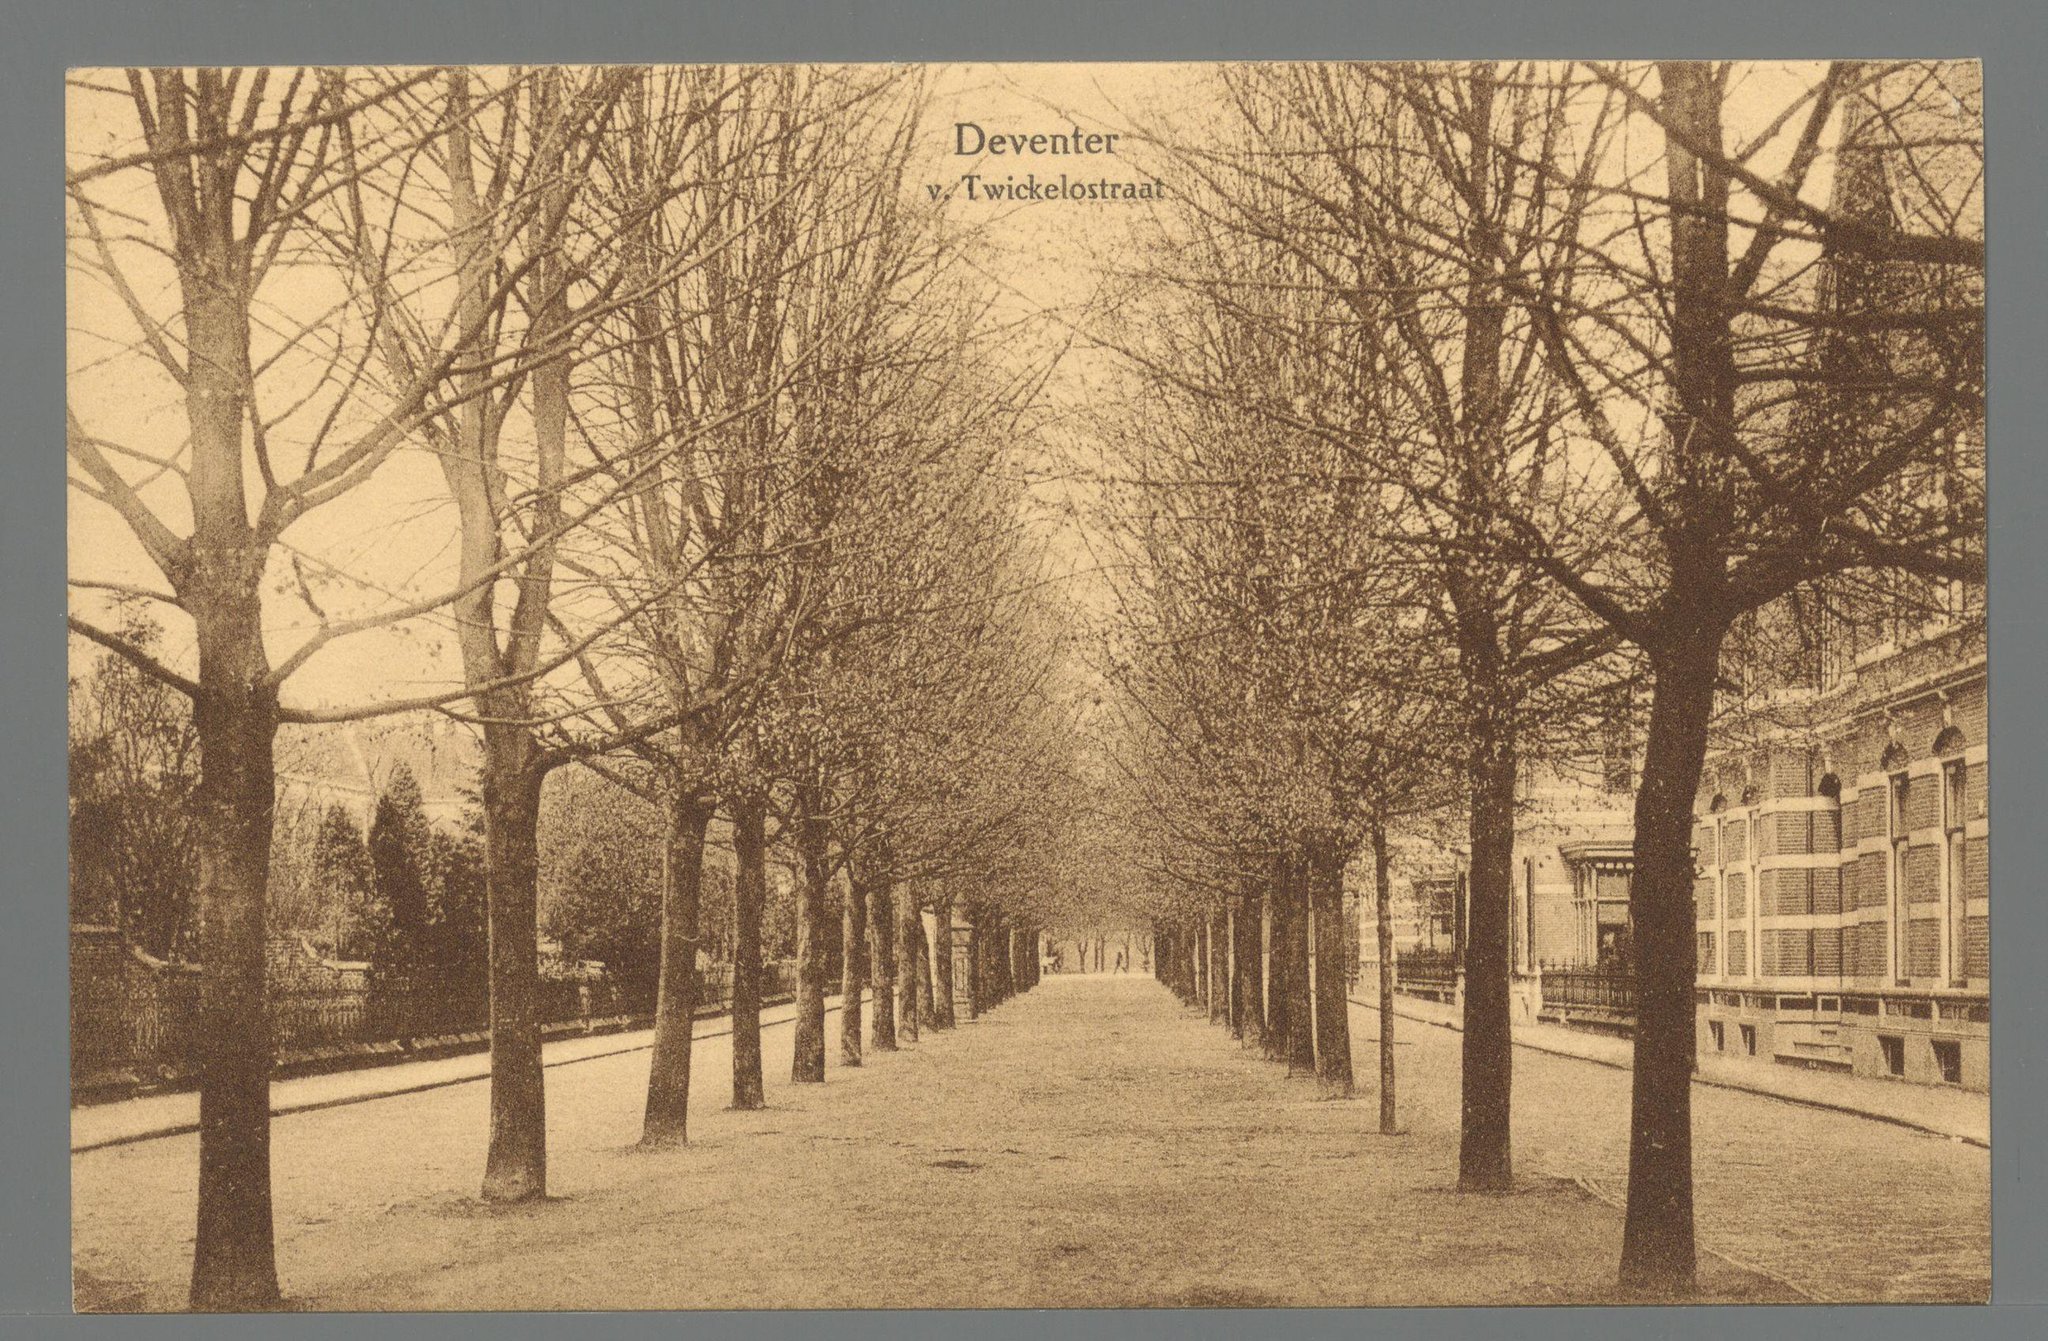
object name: ansichtkaart, prentbriefkaart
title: Deventer. V. Twickelostraat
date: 1905-1930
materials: cardboard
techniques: photograph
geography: amsterdam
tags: trees, street, deventer